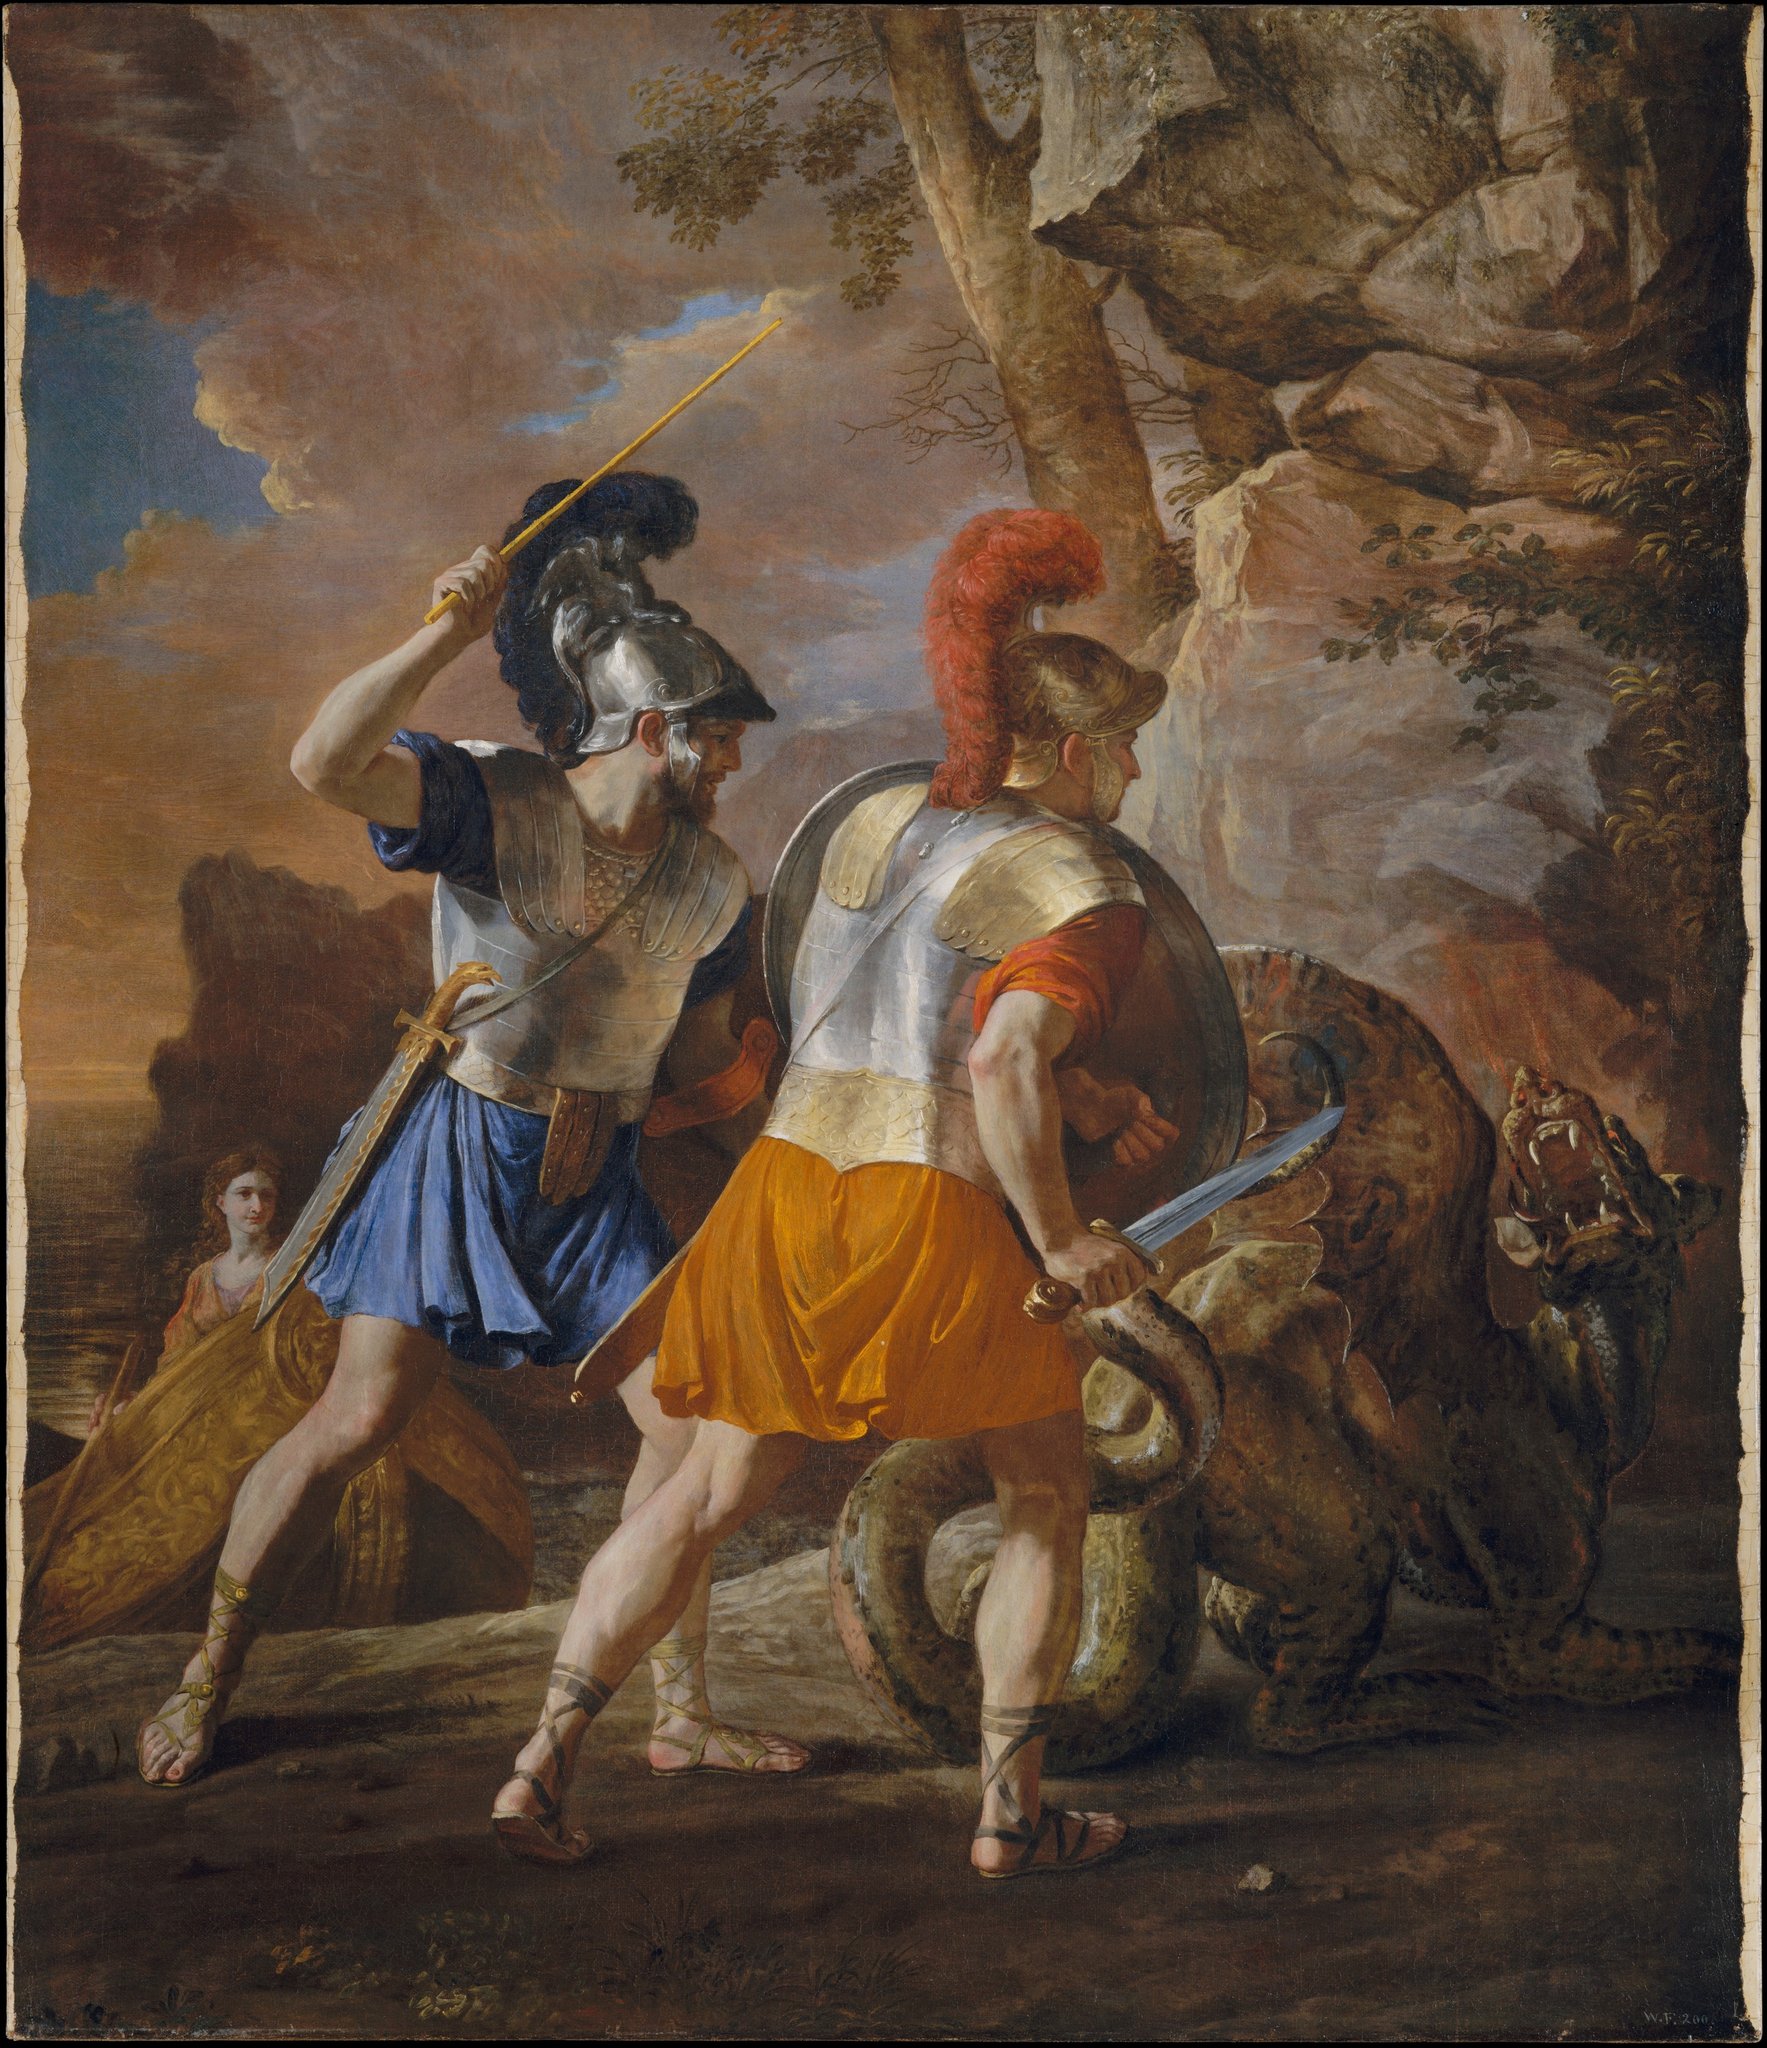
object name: painting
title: The Companions of Rinaldo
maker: nicolas poussin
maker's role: artist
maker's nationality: french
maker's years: 1594-1665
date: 1633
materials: canvas, oil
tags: shields,swords,men,dragons